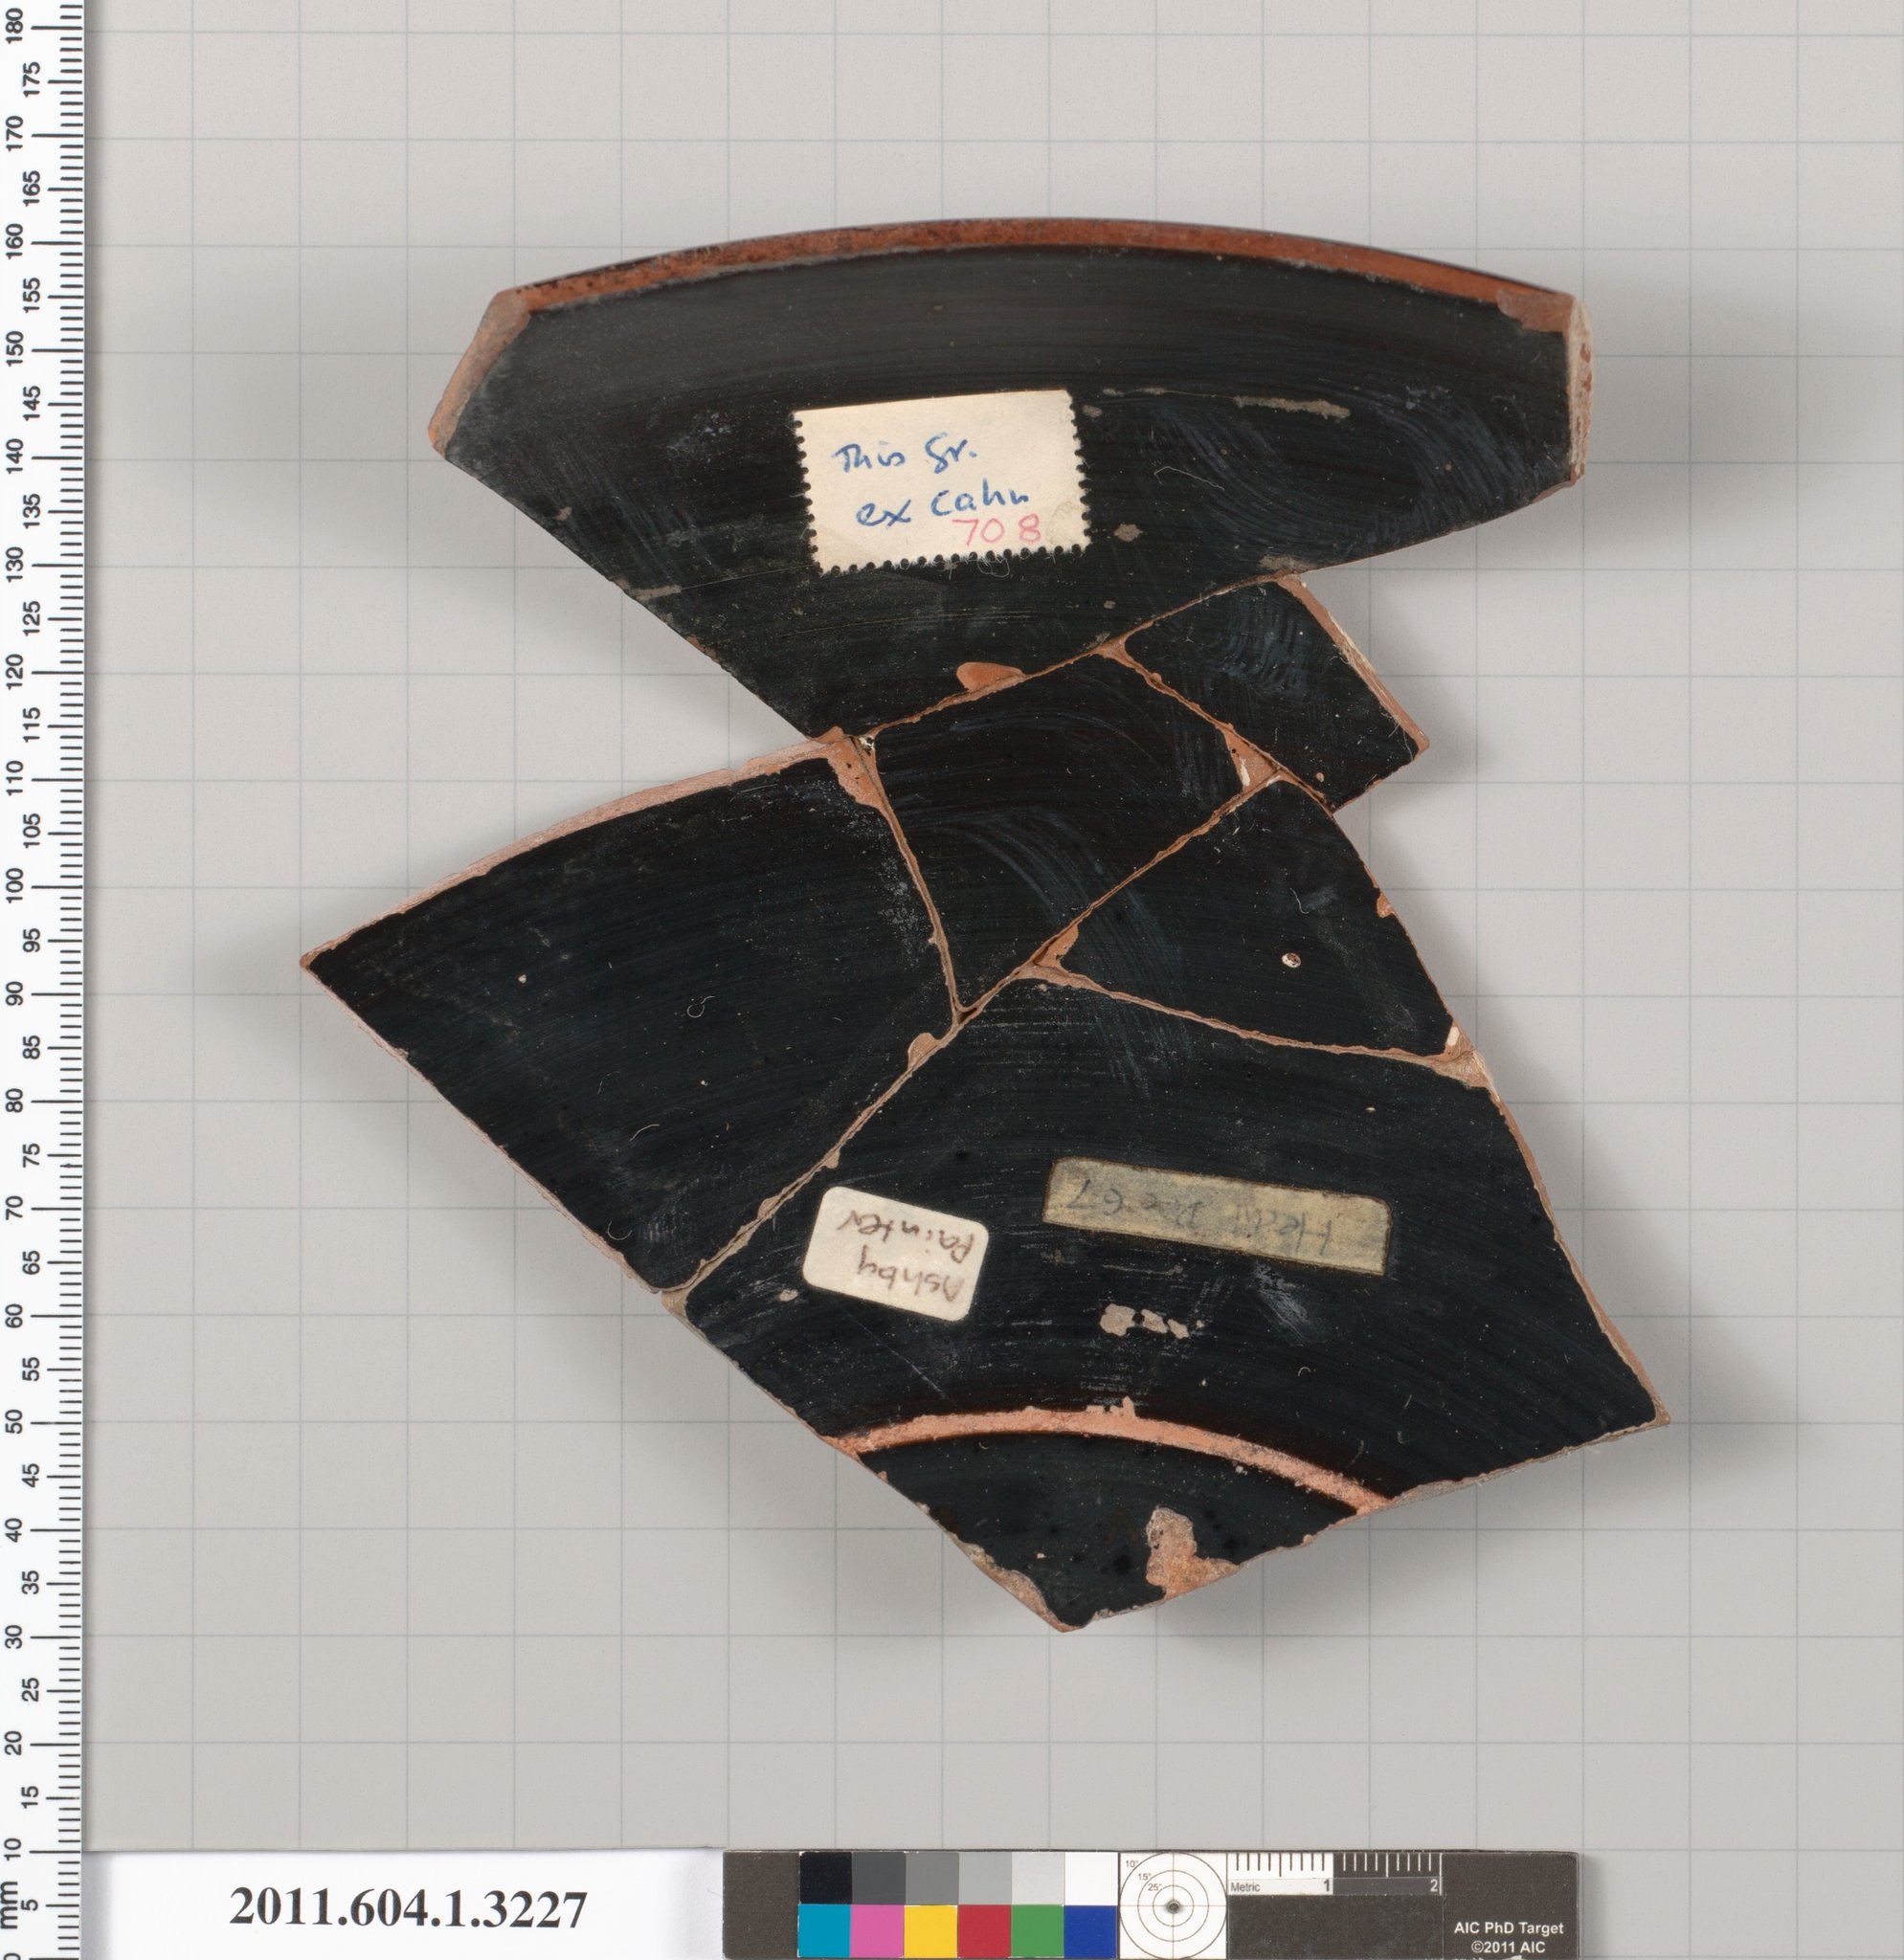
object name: kylix fragment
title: Terracotta fragment of a kylix (drinking cup)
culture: greek, attic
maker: argos painter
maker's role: artist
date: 515-500 BCE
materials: terracotta